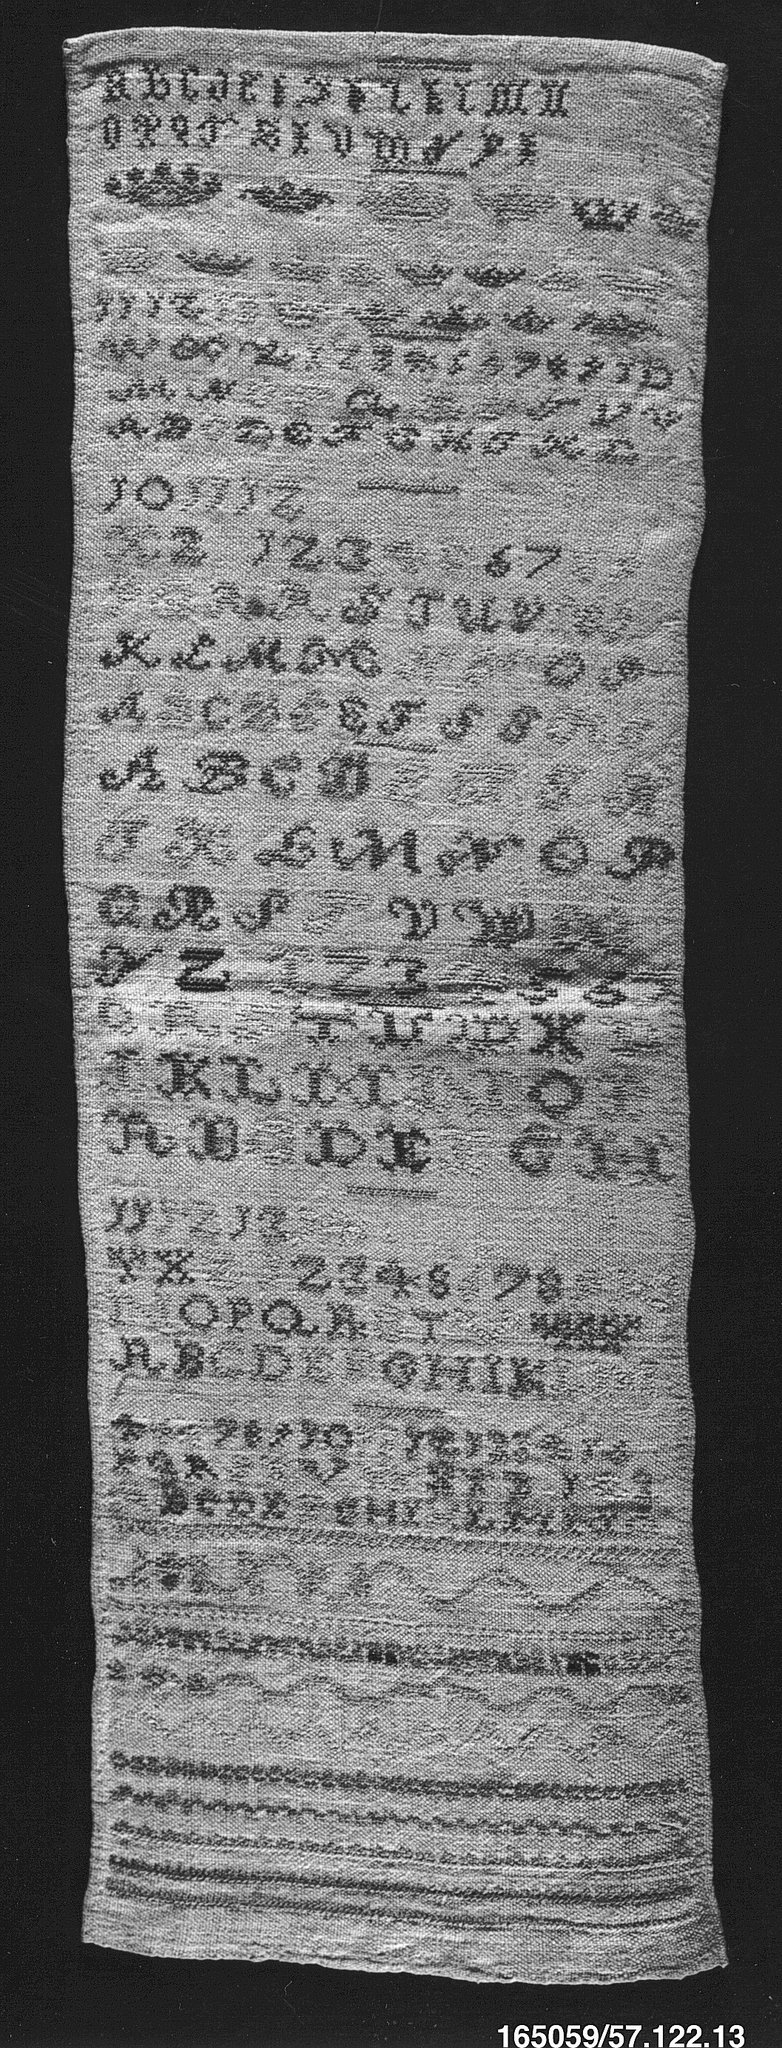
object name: sampler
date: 1701-1800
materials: linen, silk